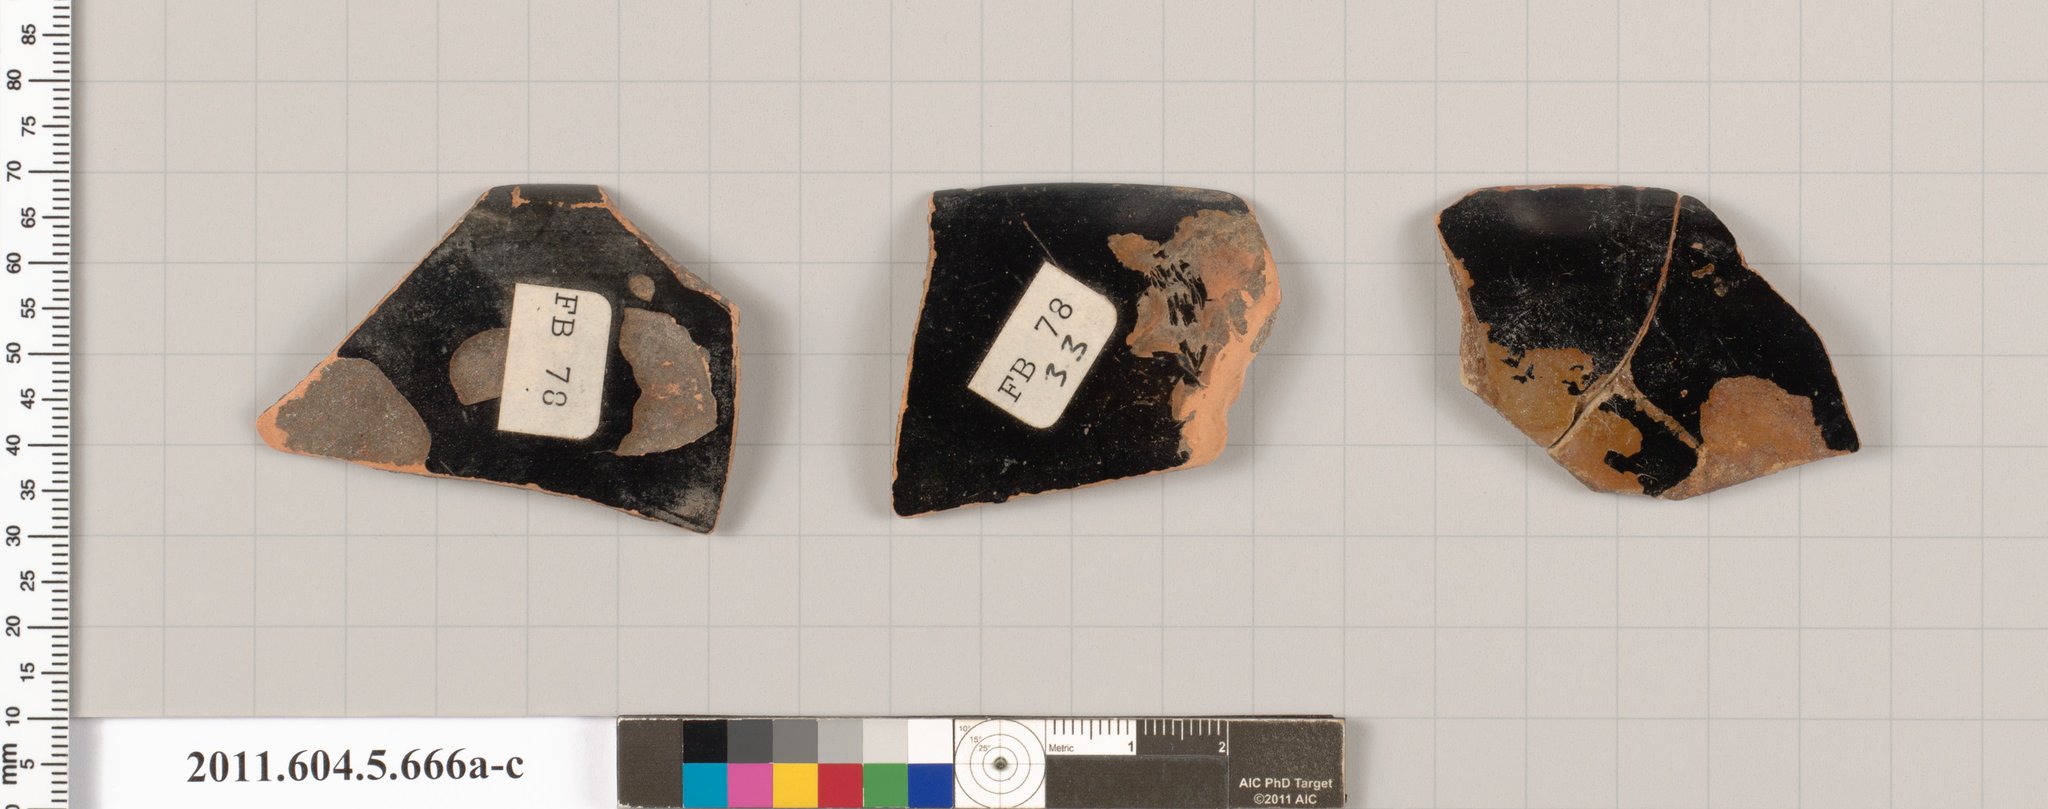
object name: kylix fragment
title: Terracotta rim fragments of kylikes (drinking cups)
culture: greek, attic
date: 600-401 BCE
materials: terracotta